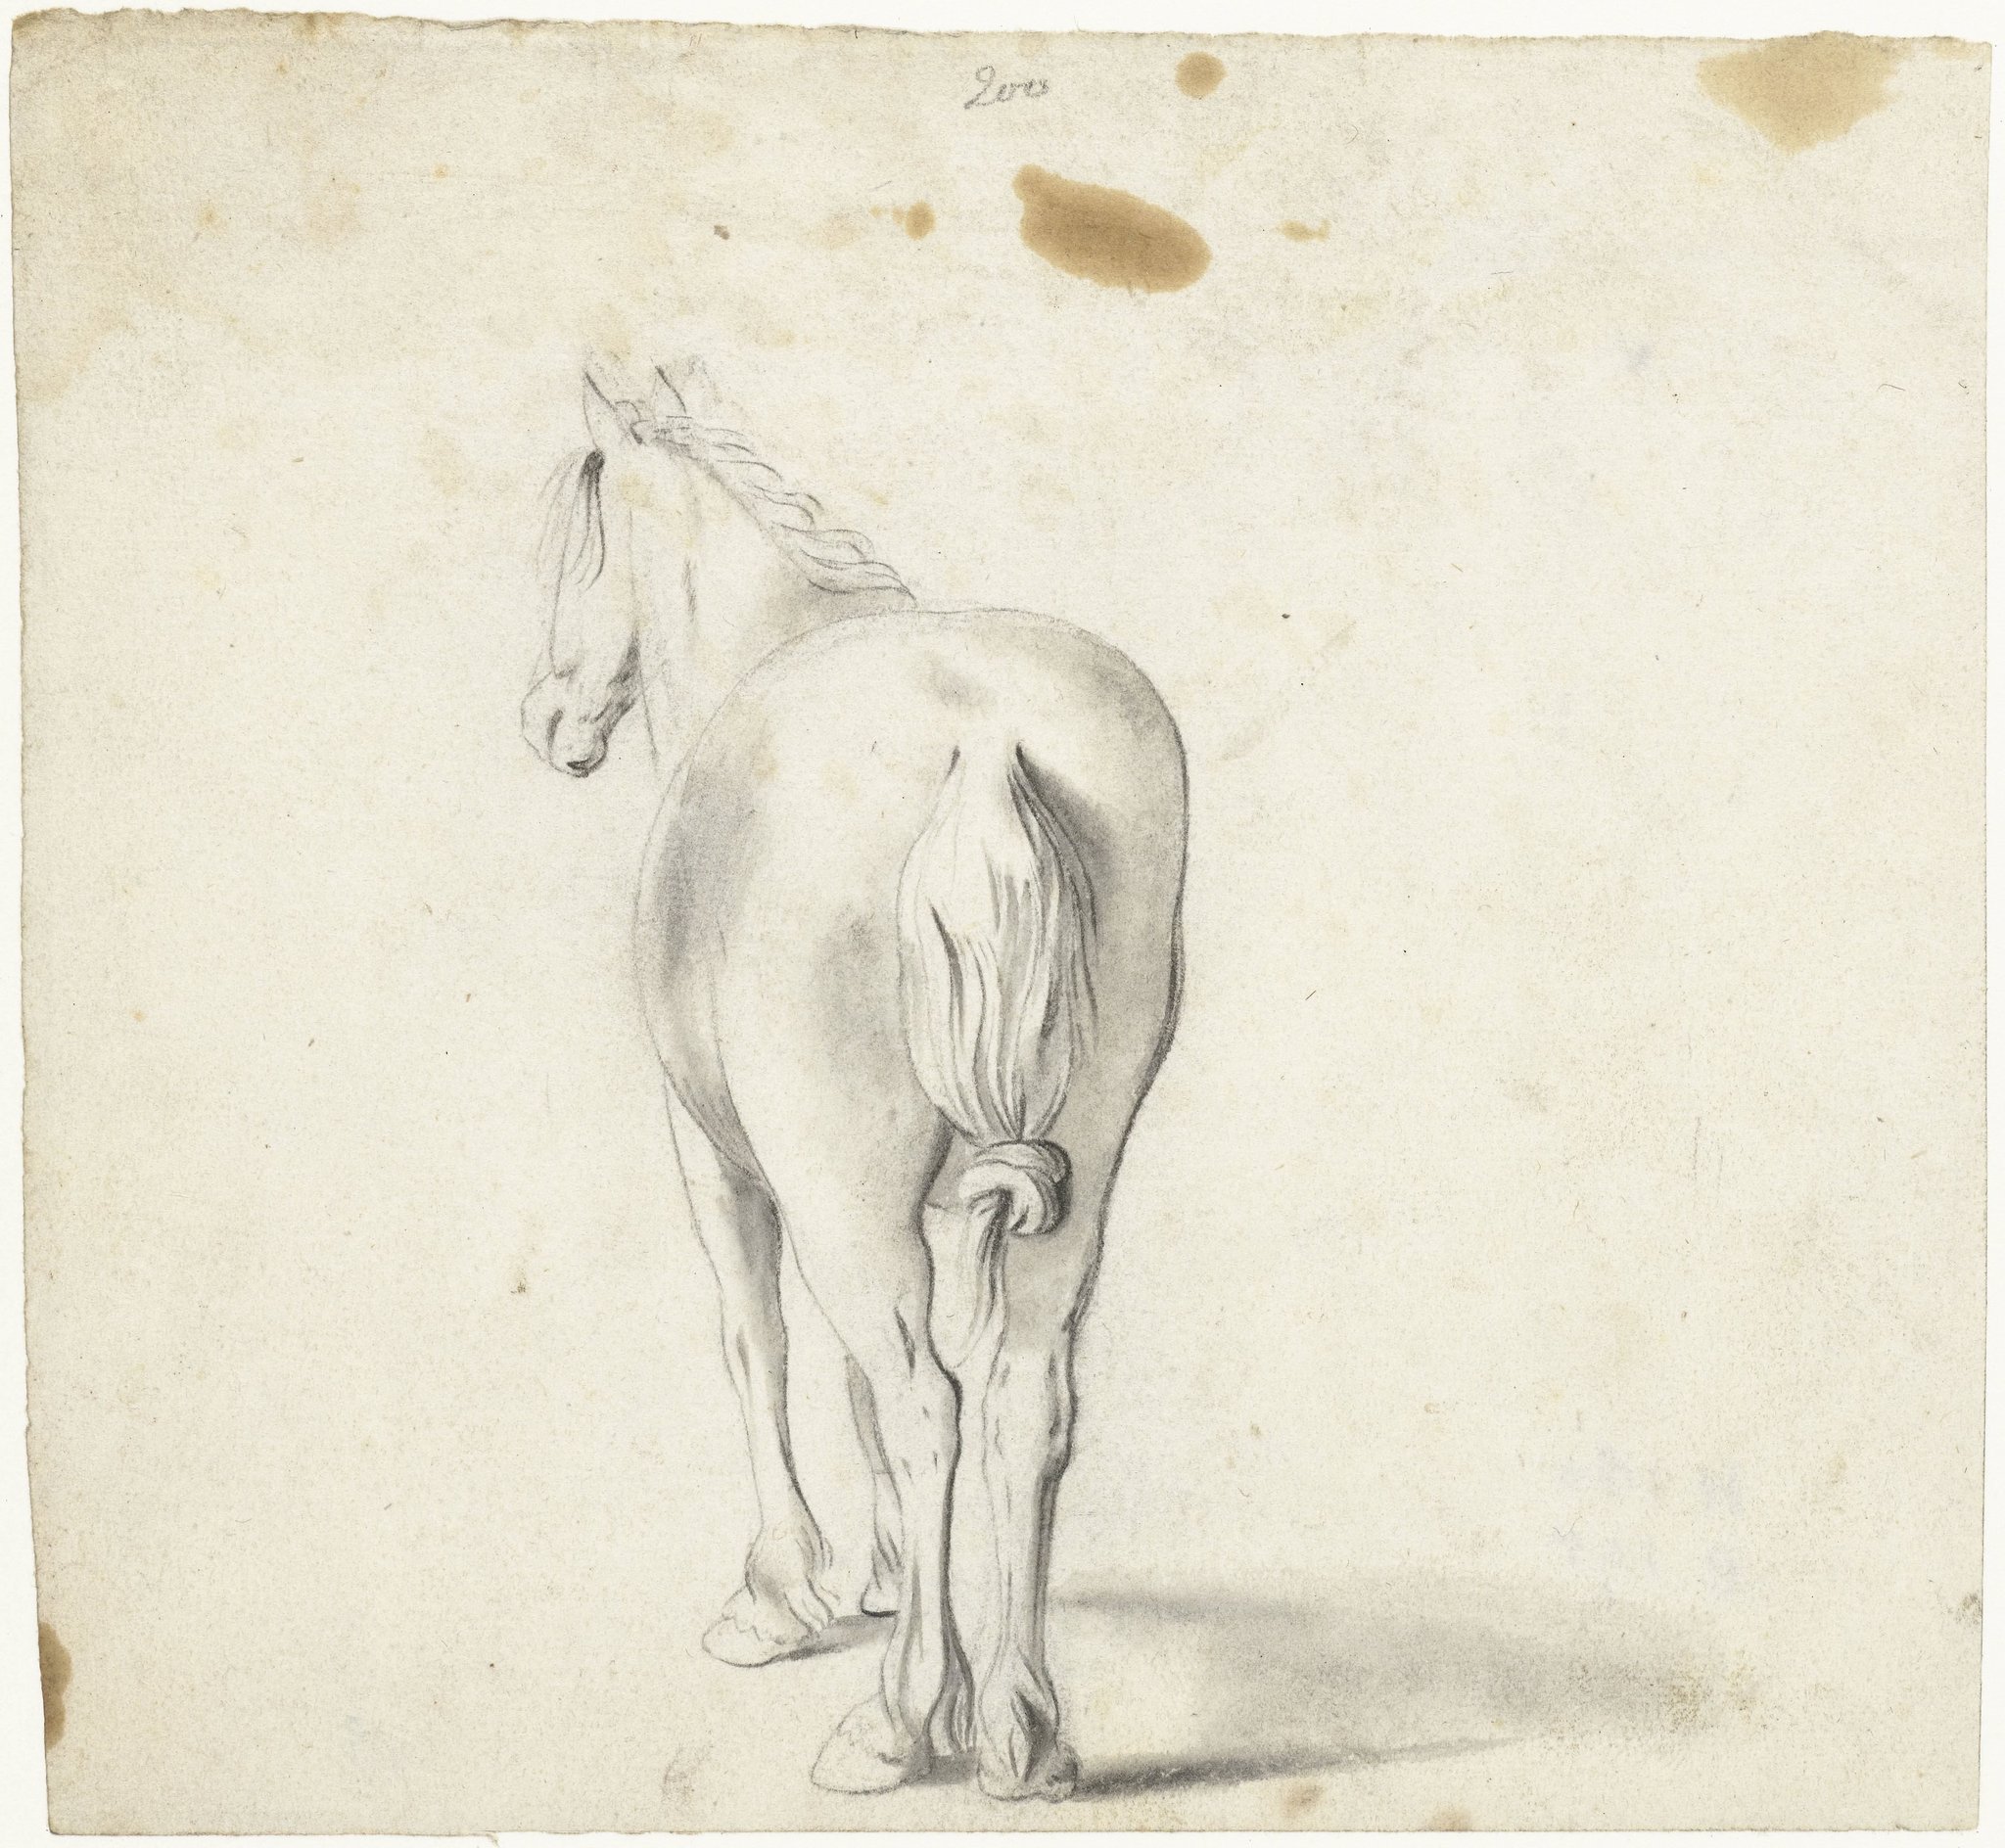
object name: drawing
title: Paard met geknoopte staart, van achteren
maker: moses ter borch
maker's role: draughtsman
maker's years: 1645-1667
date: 1660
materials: chalk, paper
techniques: brush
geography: zwolle